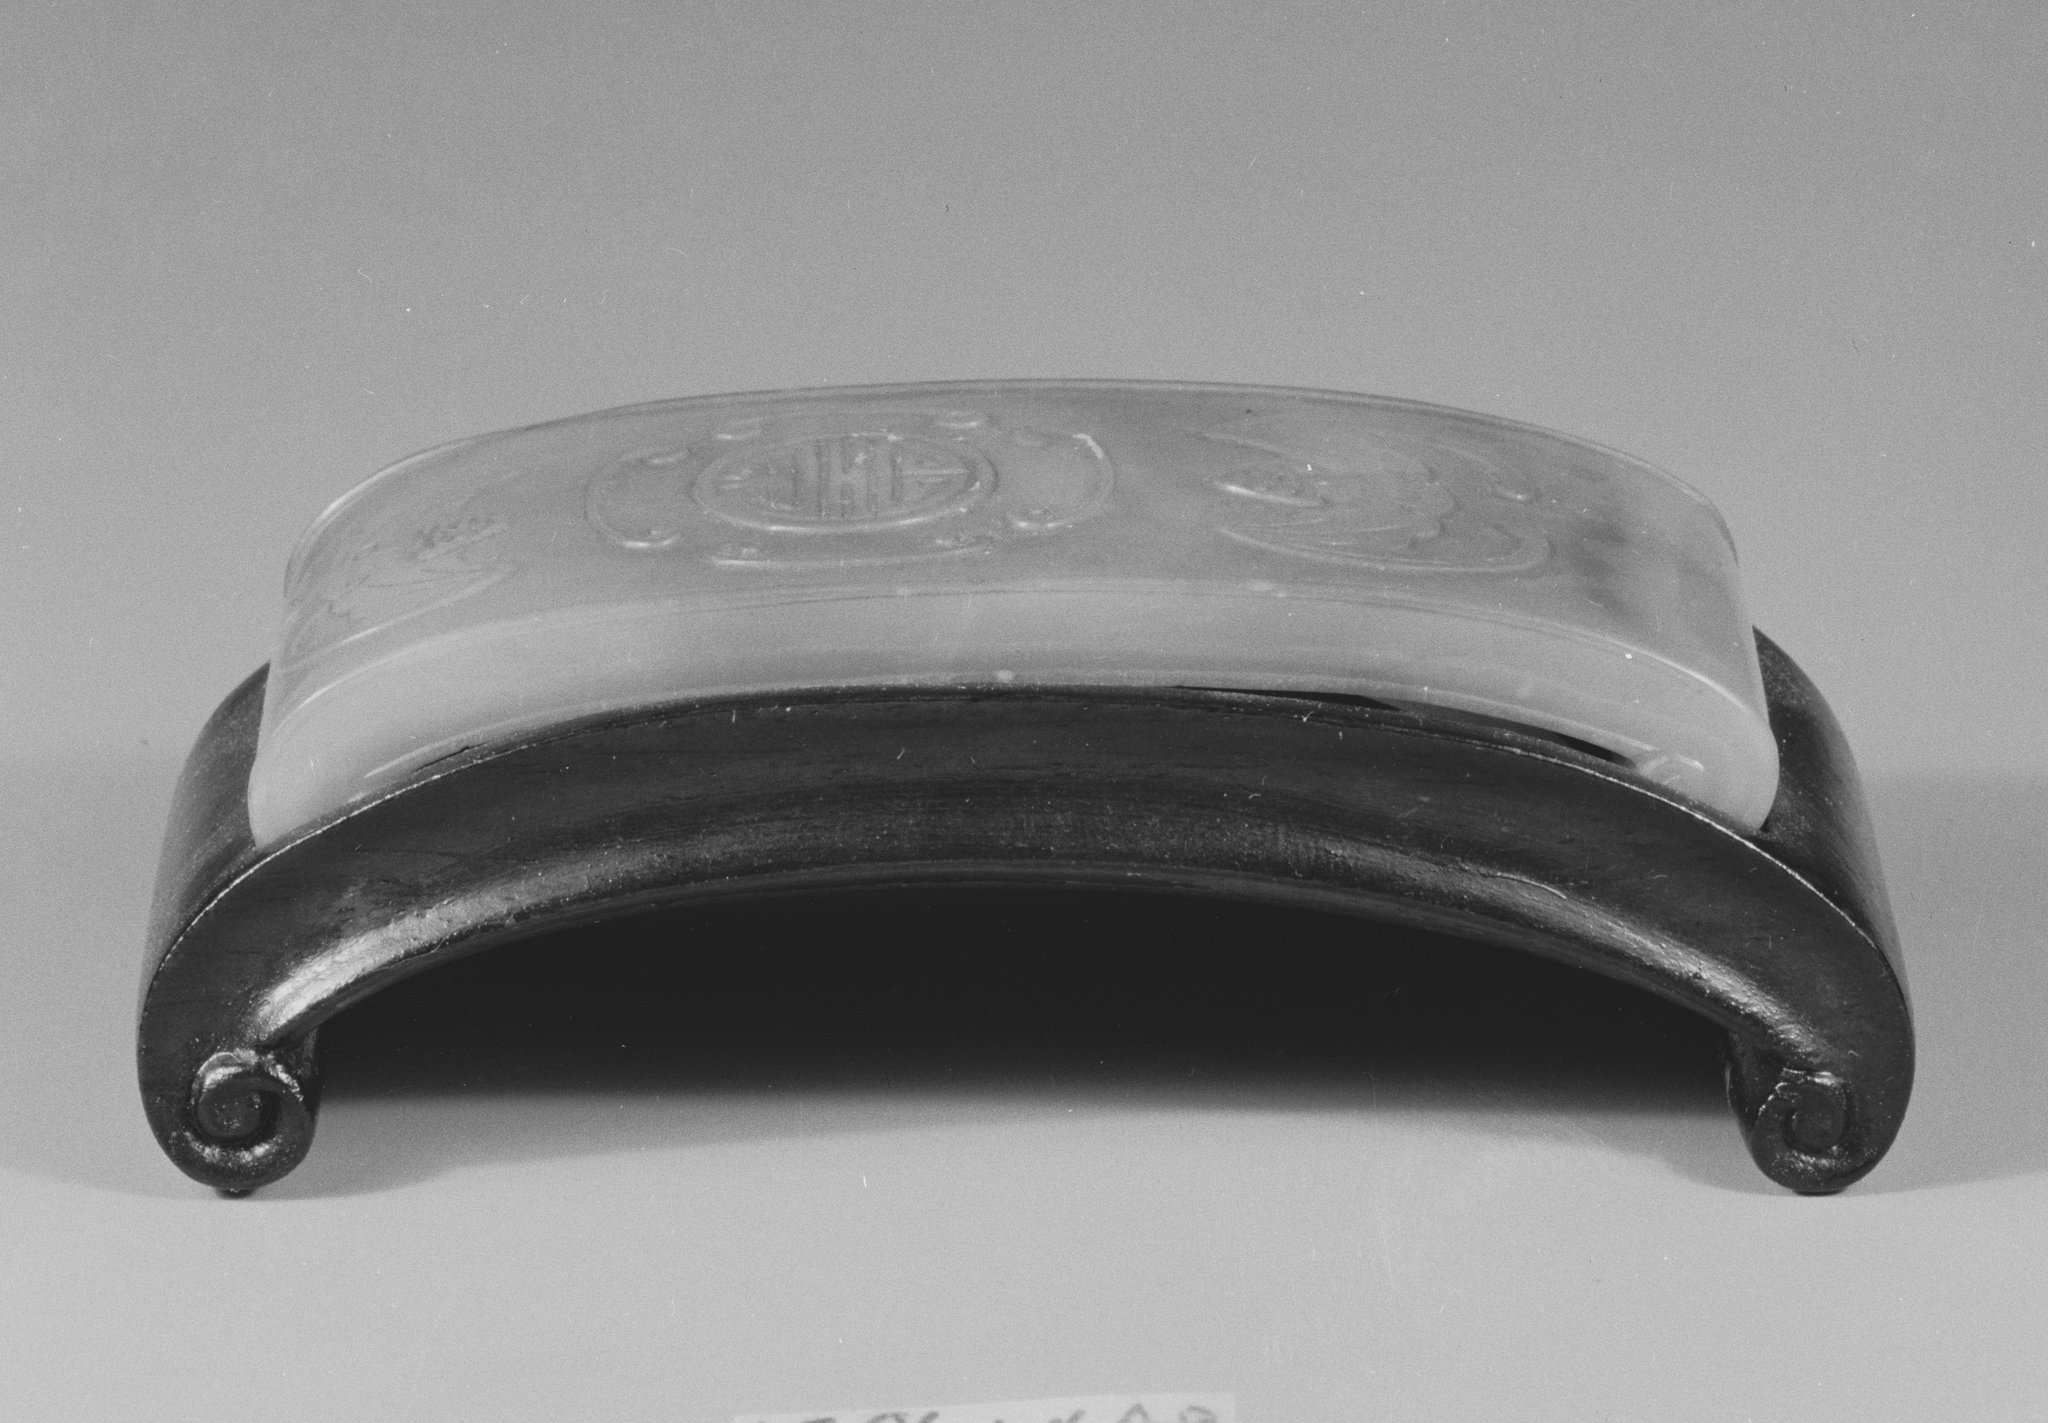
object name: scabbard ornament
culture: chinese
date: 1701-1800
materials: jade, wood